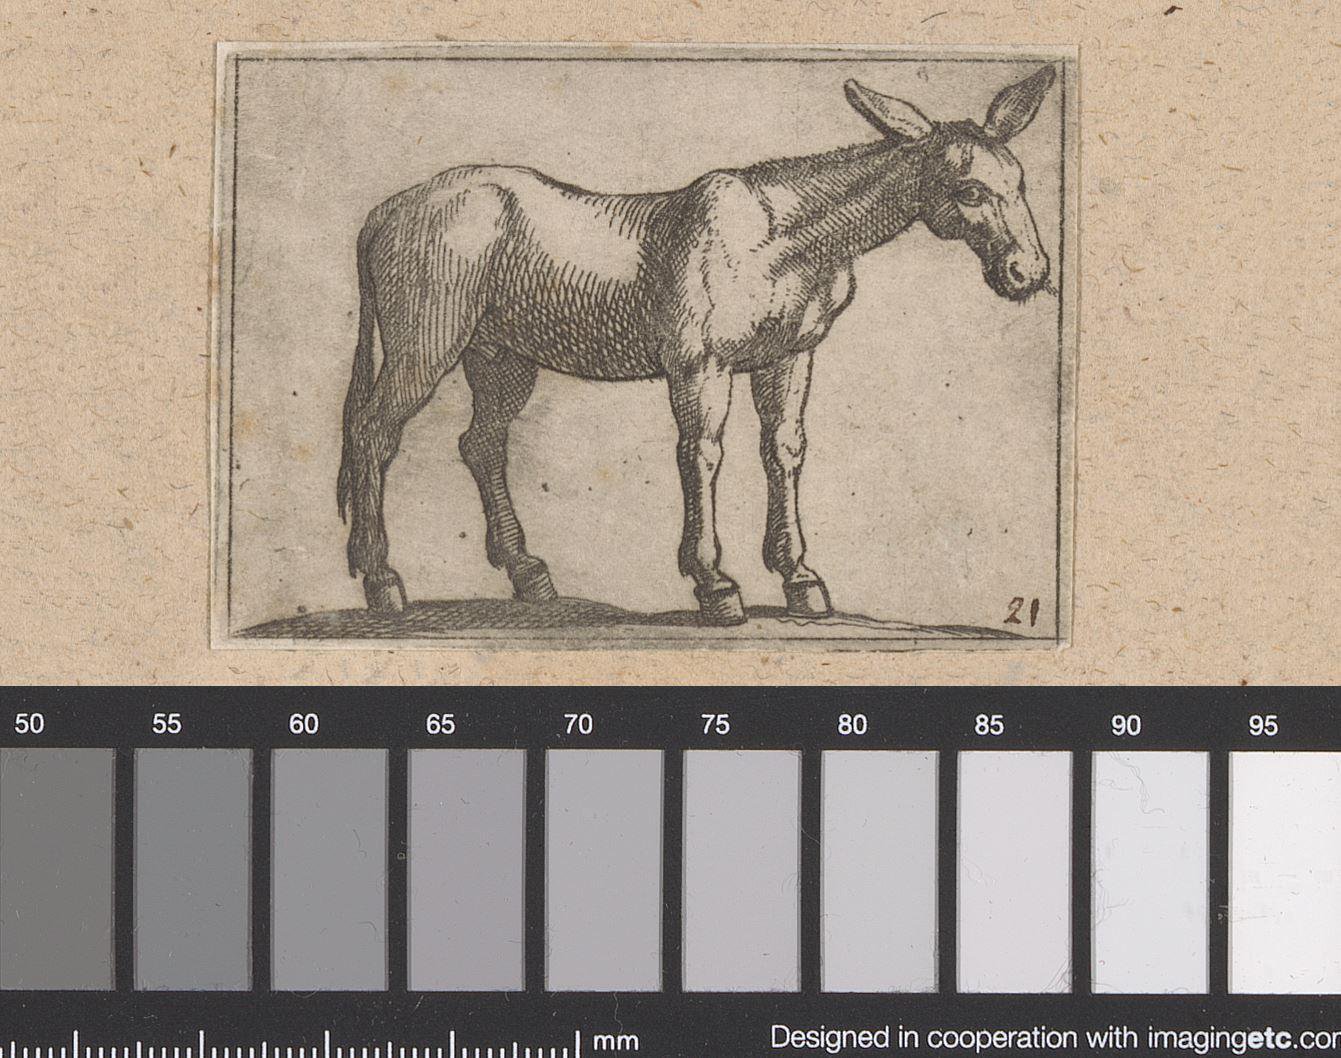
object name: print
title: Verschillende dieren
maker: antonio tempesta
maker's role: draughtsman, painter, print maker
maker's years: 1555-1630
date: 1565-1630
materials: paper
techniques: etching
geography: italy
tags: ass, donkey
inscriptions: number: ‘21’, collector's mark: Lugt 11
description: Deze prent maakt deel uit van een reeks van 28 prenten van dieren.